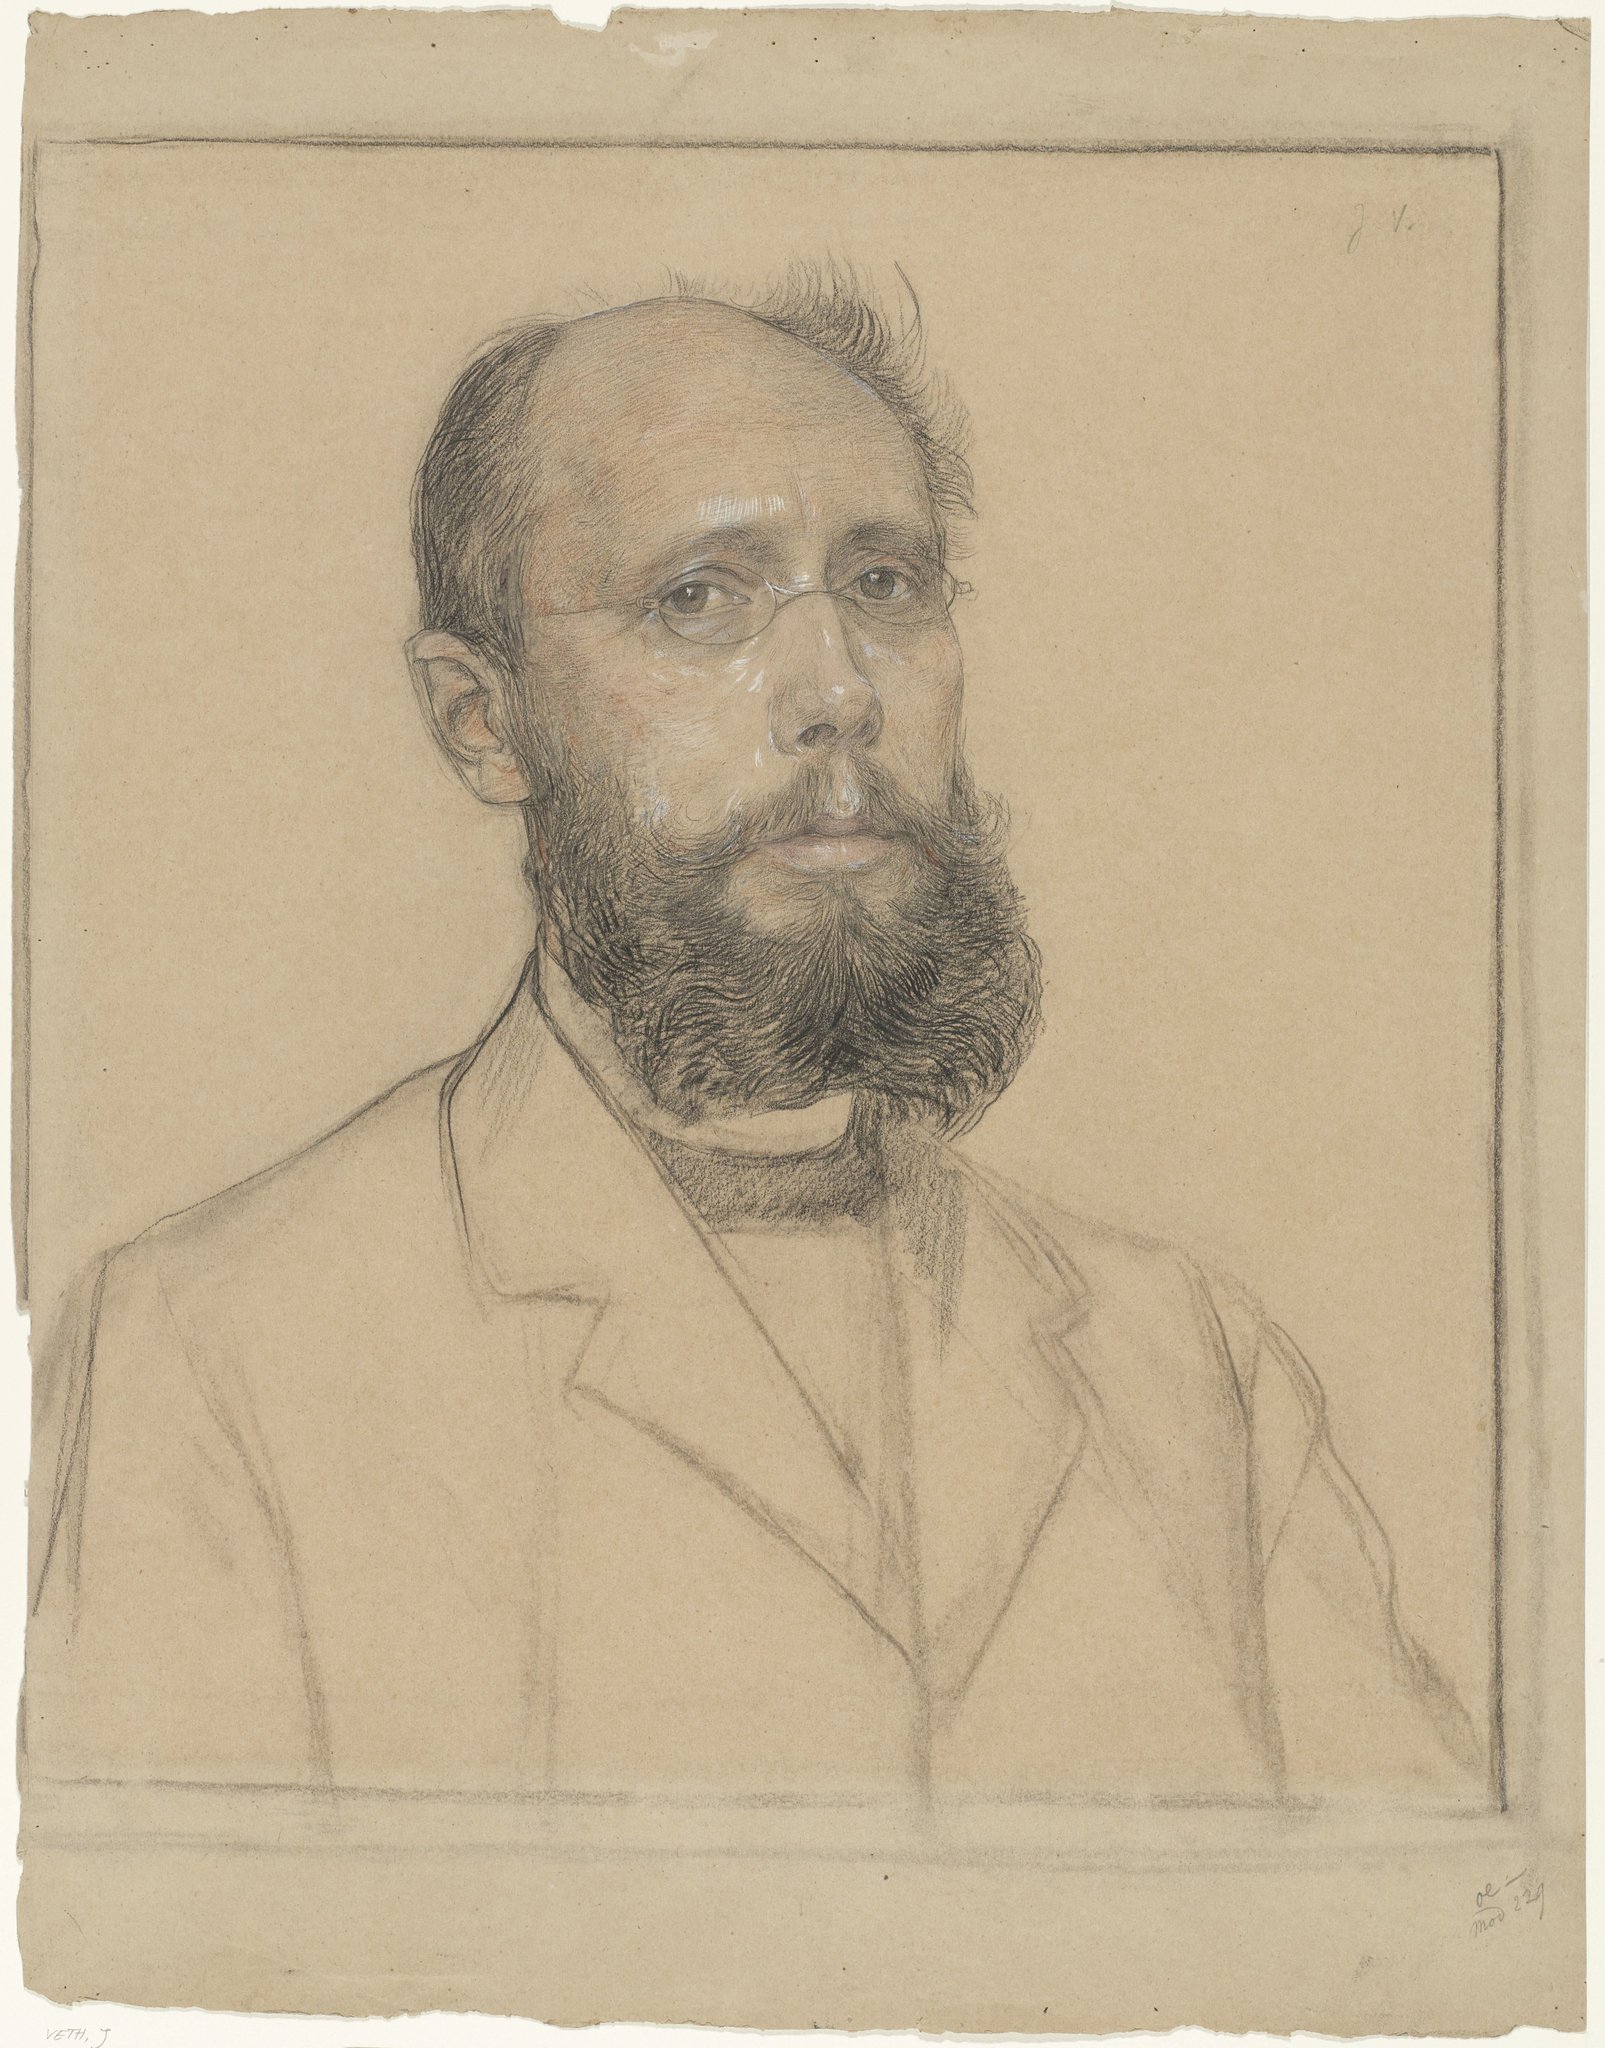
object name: drawing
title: Portret van Samuel Muller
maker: jan veth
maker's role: designer, draughtsman, painter, print maker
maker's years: 1864-1925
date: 1874-1925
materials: chalk, paint, paper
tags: samuel muller (1848-1922), historical persons